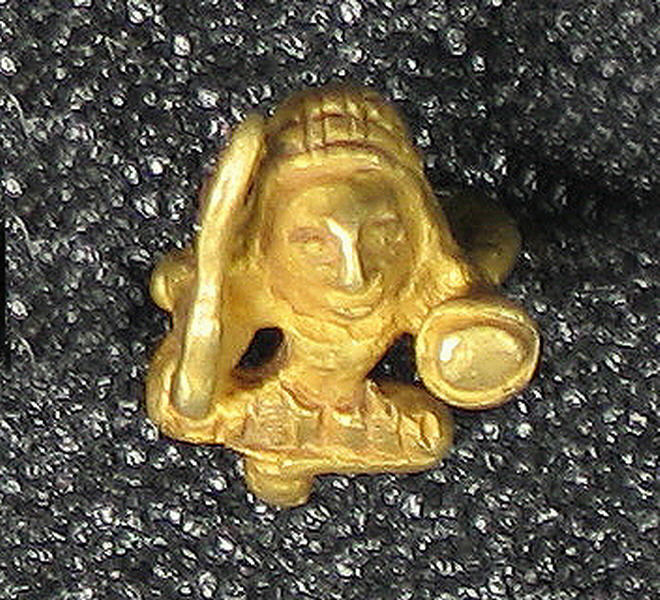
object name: earring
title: Earring with Male Figure with Sword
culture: indonesian, central java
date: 701-1200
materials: gold